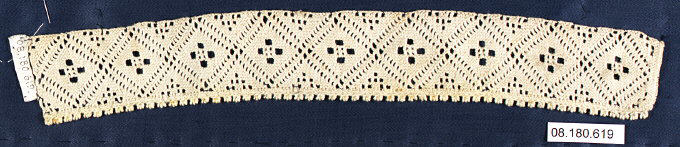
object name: fragment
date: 1701-1800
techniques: lace